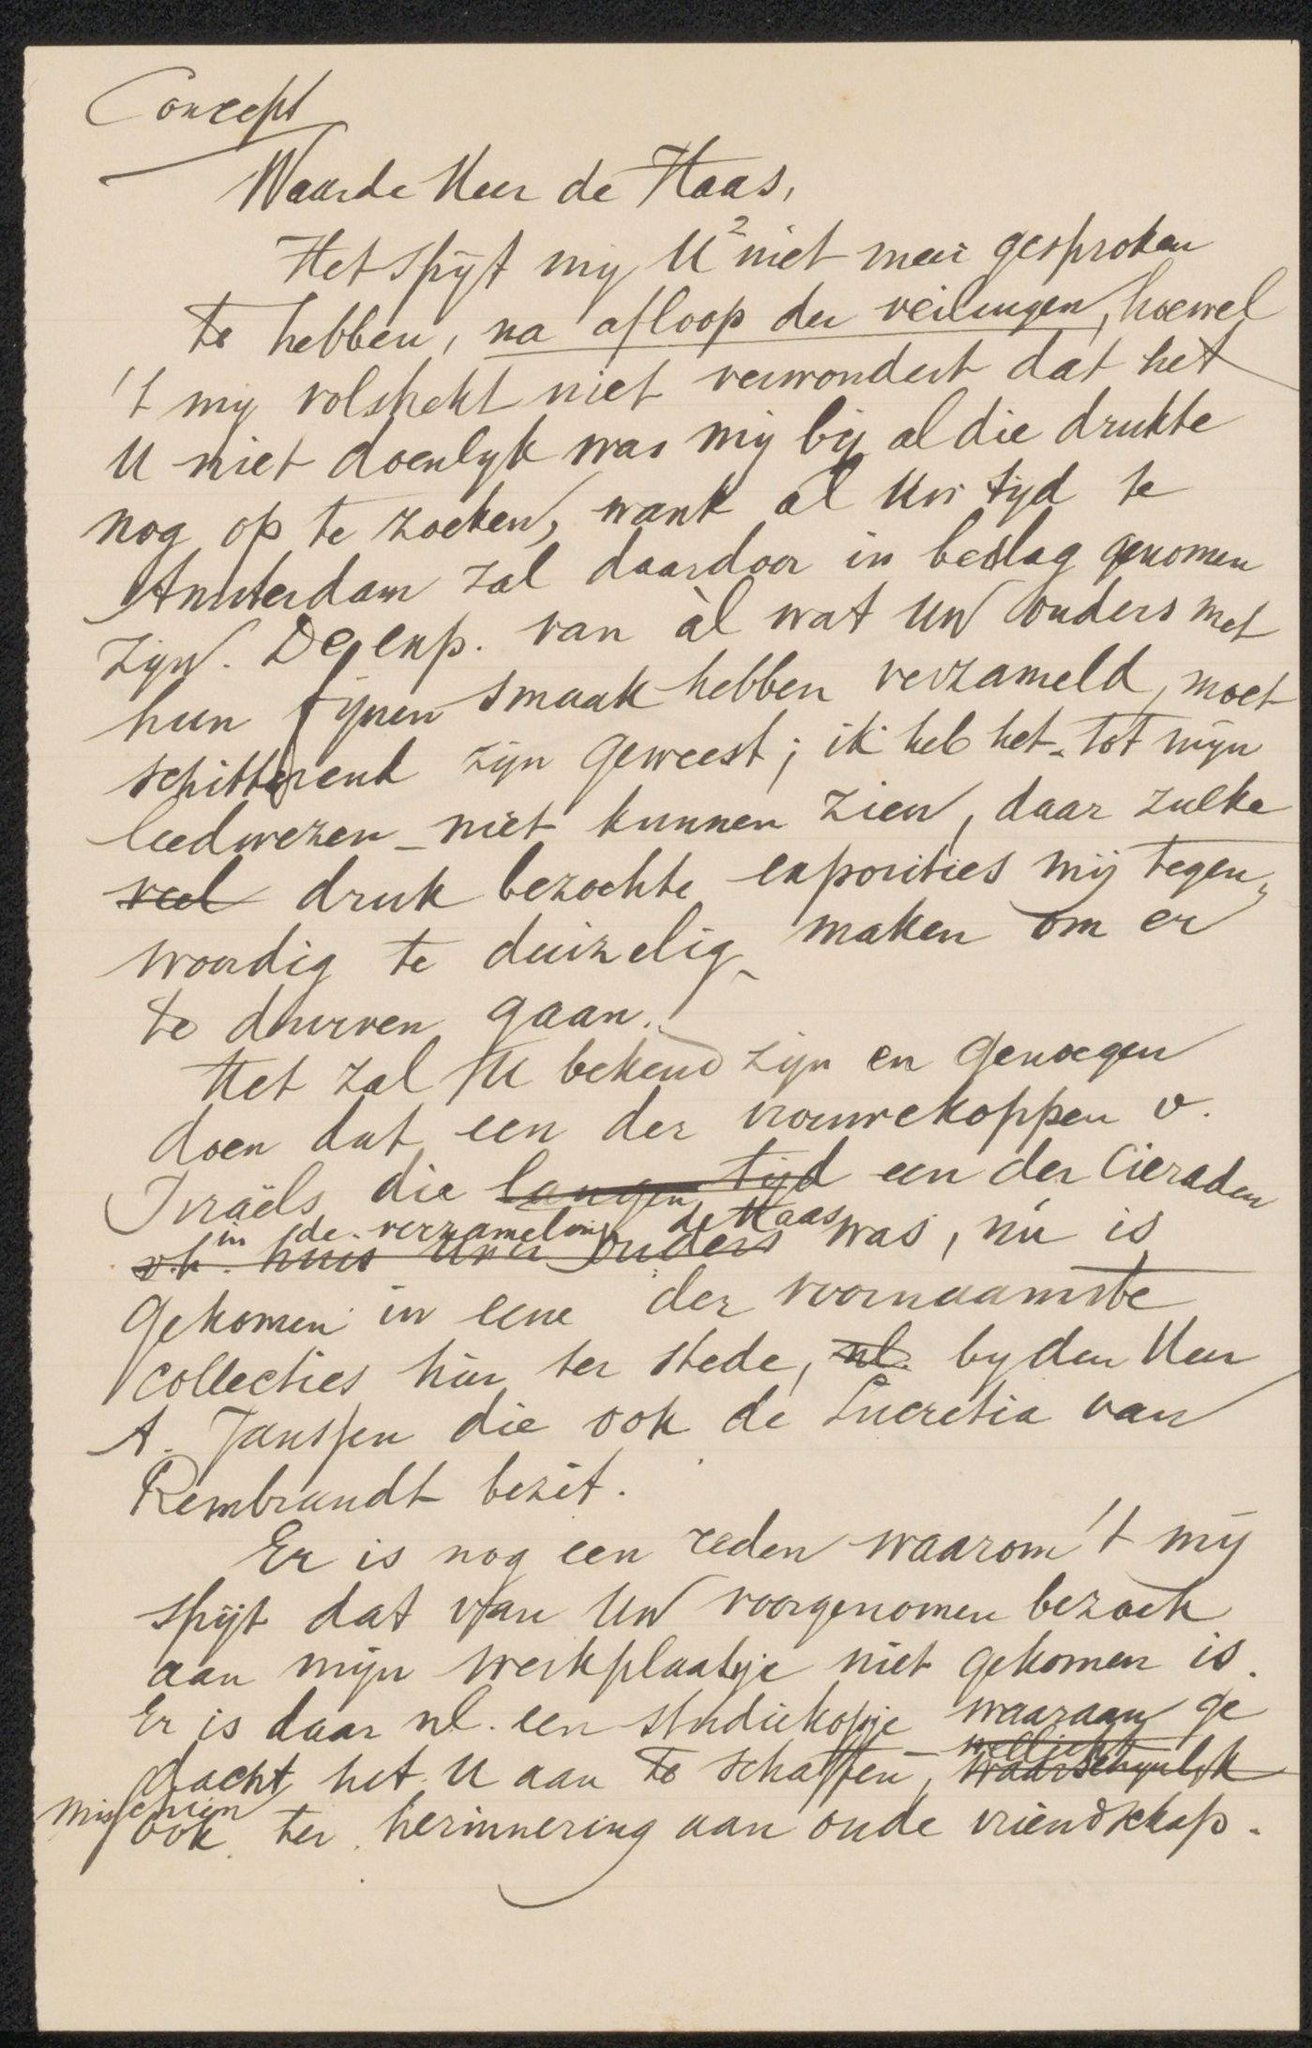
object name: letter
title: Conceptbrief aan de heer De Haas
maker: august allebé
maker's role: draughtsman, print maker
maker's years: 1838-1927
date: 1848-1927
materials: ink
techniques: pen, writing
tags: jozef israëls, art trade, art shop, drawing, workshop, studio of the artist (in general), exhibition ~ art, art collecting